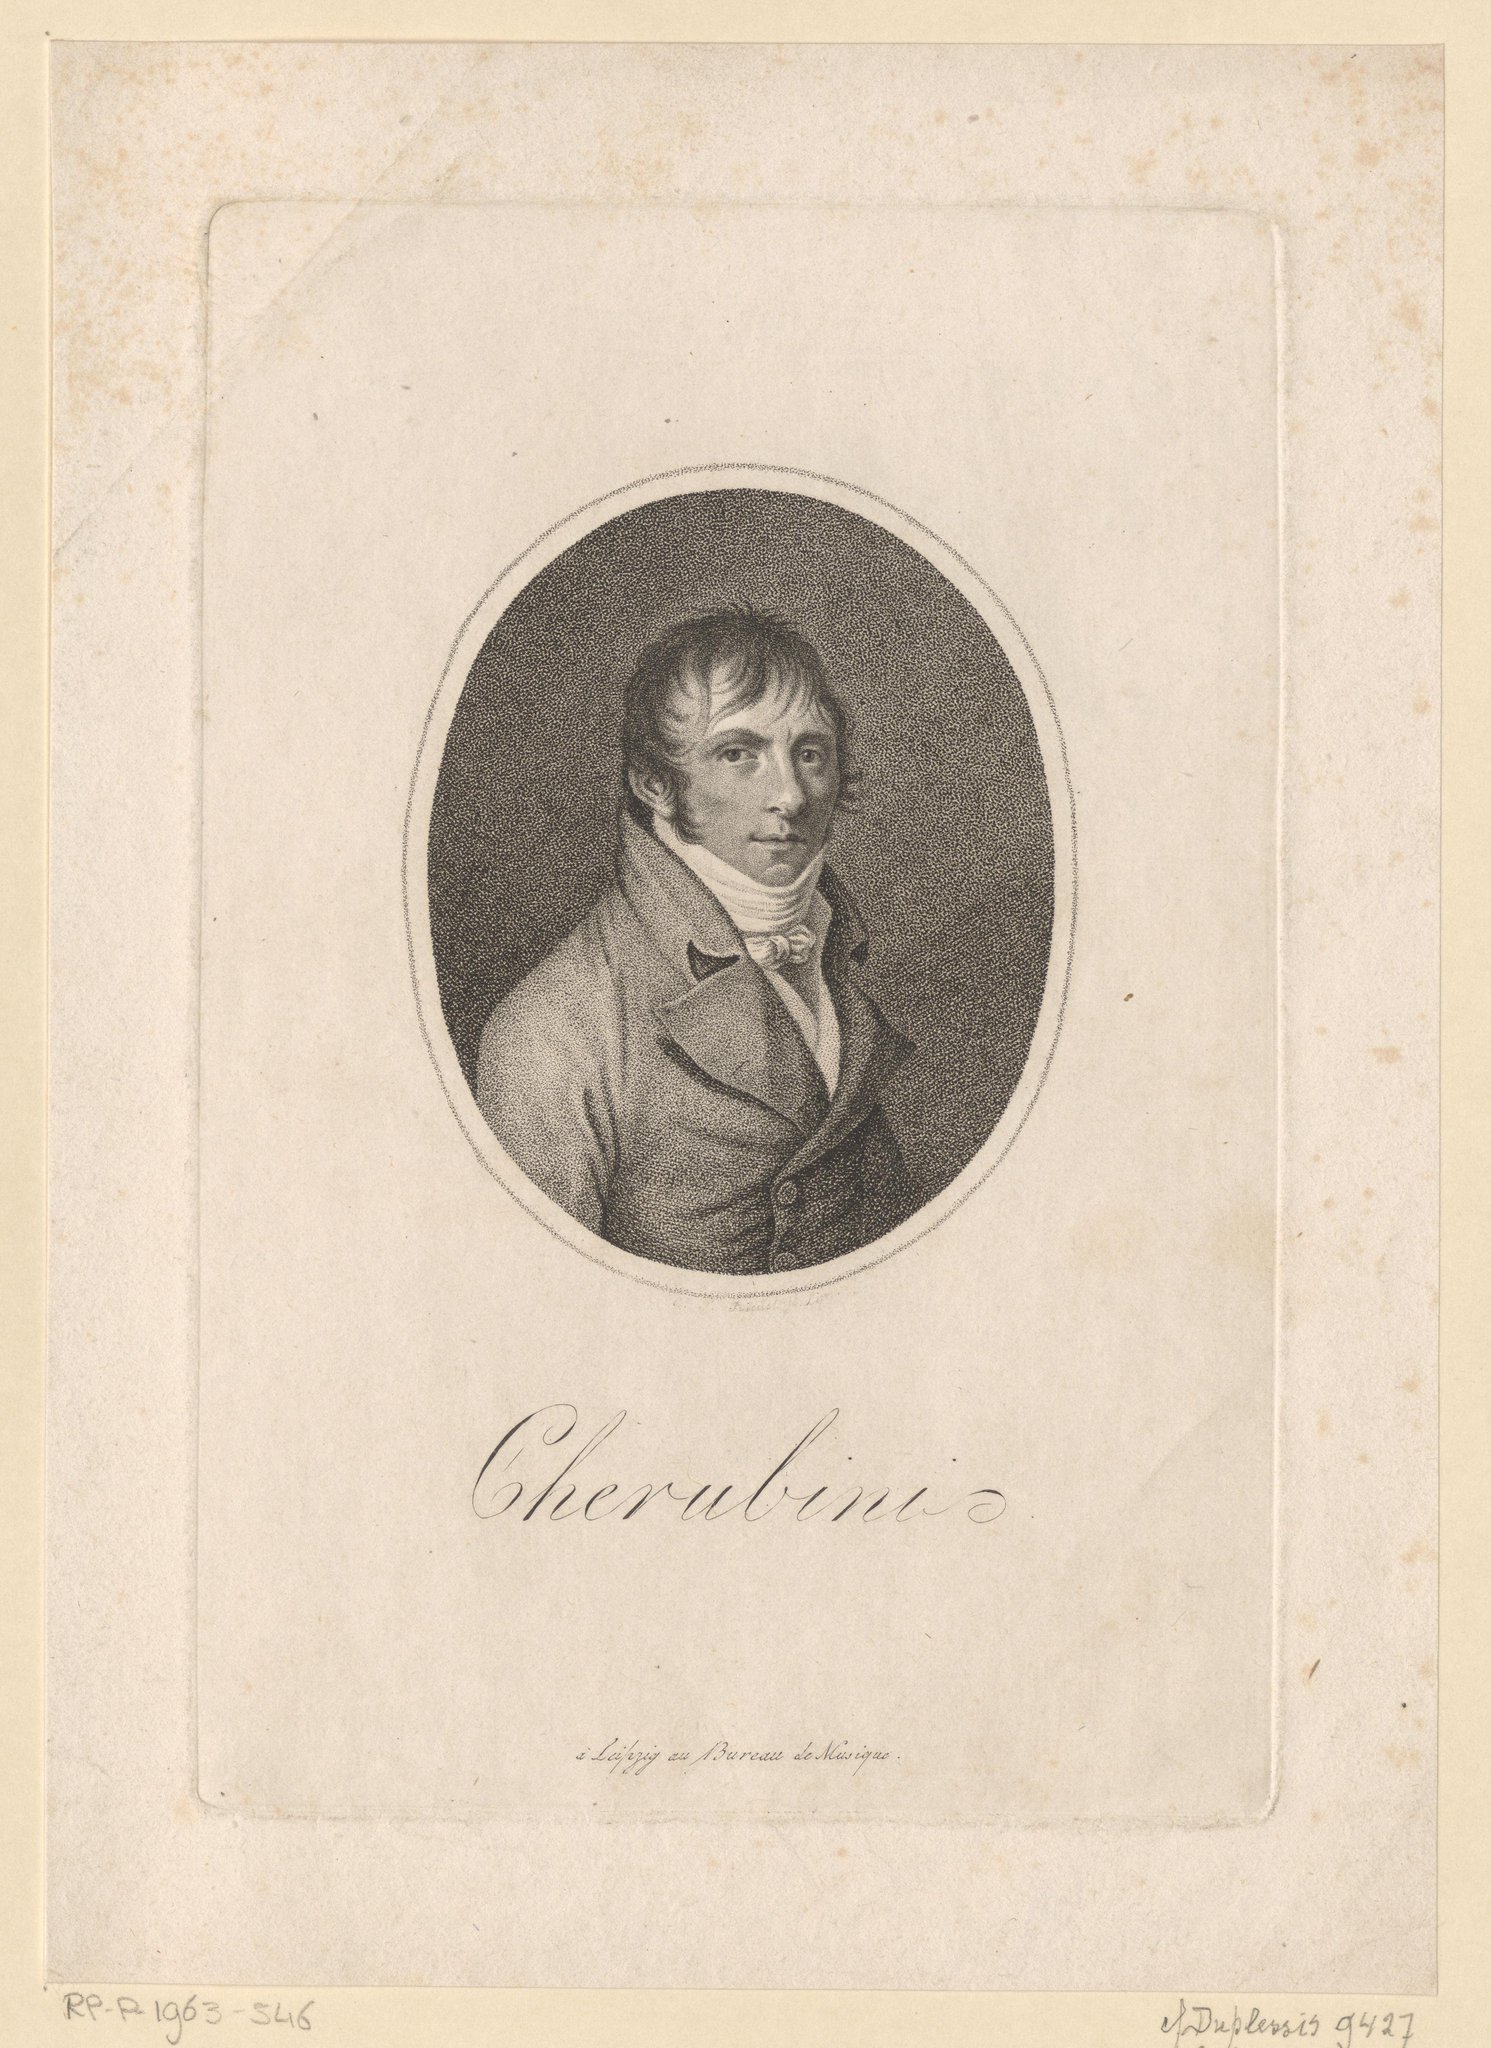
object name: print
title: Portret van Luigi Cherubini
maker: karl traugott riedel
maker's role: print maker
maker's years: 1769-1832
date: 1800-1832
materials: paper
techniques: stippling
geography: leipzig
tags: historical persons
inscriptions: collector's mark: Lugt 2282